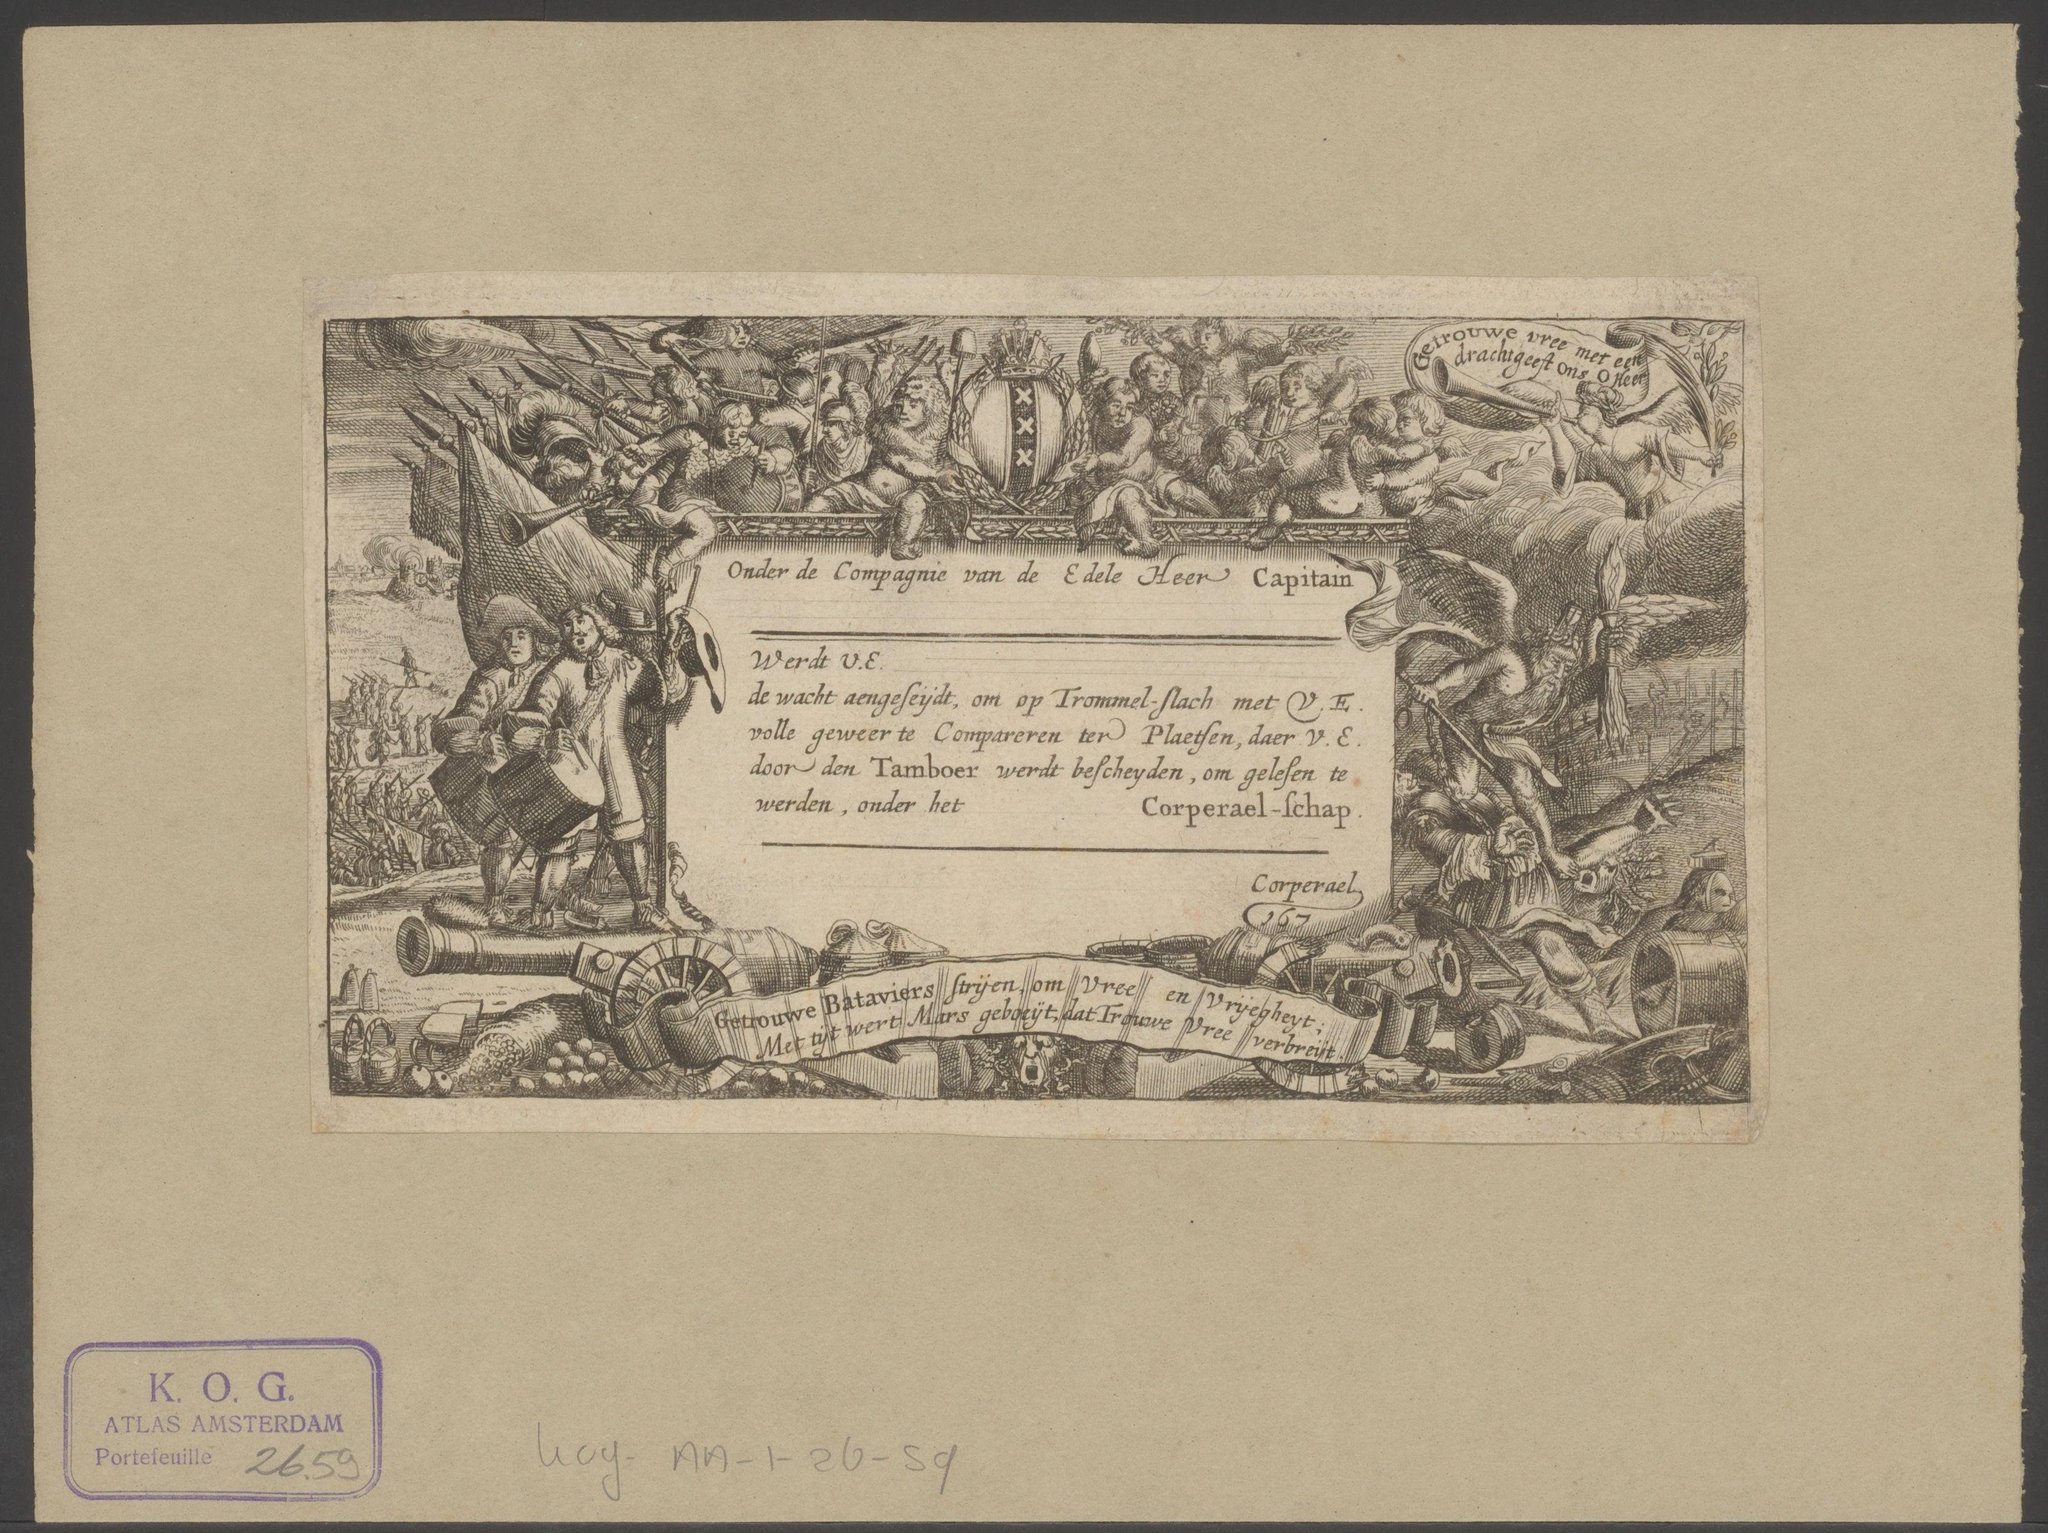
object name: schuttersbiljet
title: Schuttersbrief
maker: Anonymous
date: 1670-1679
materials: paper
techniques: engraving, etching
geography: northern netherlands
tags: coat of arms (as symbol of the state, etc.) (+ city; municipal), warfare; military affairs (+ citizen soldiery, civil guard, citizen militia), cupids: 'amores', 'amoretti', 'putti', father time, man with wings and scythe, amsterdam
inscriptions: collector's mark: Lugt 1641b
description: Onderwerpsrubriek binnen de Atlas Amsterdam: Schutters-oproepingsbriefjes.